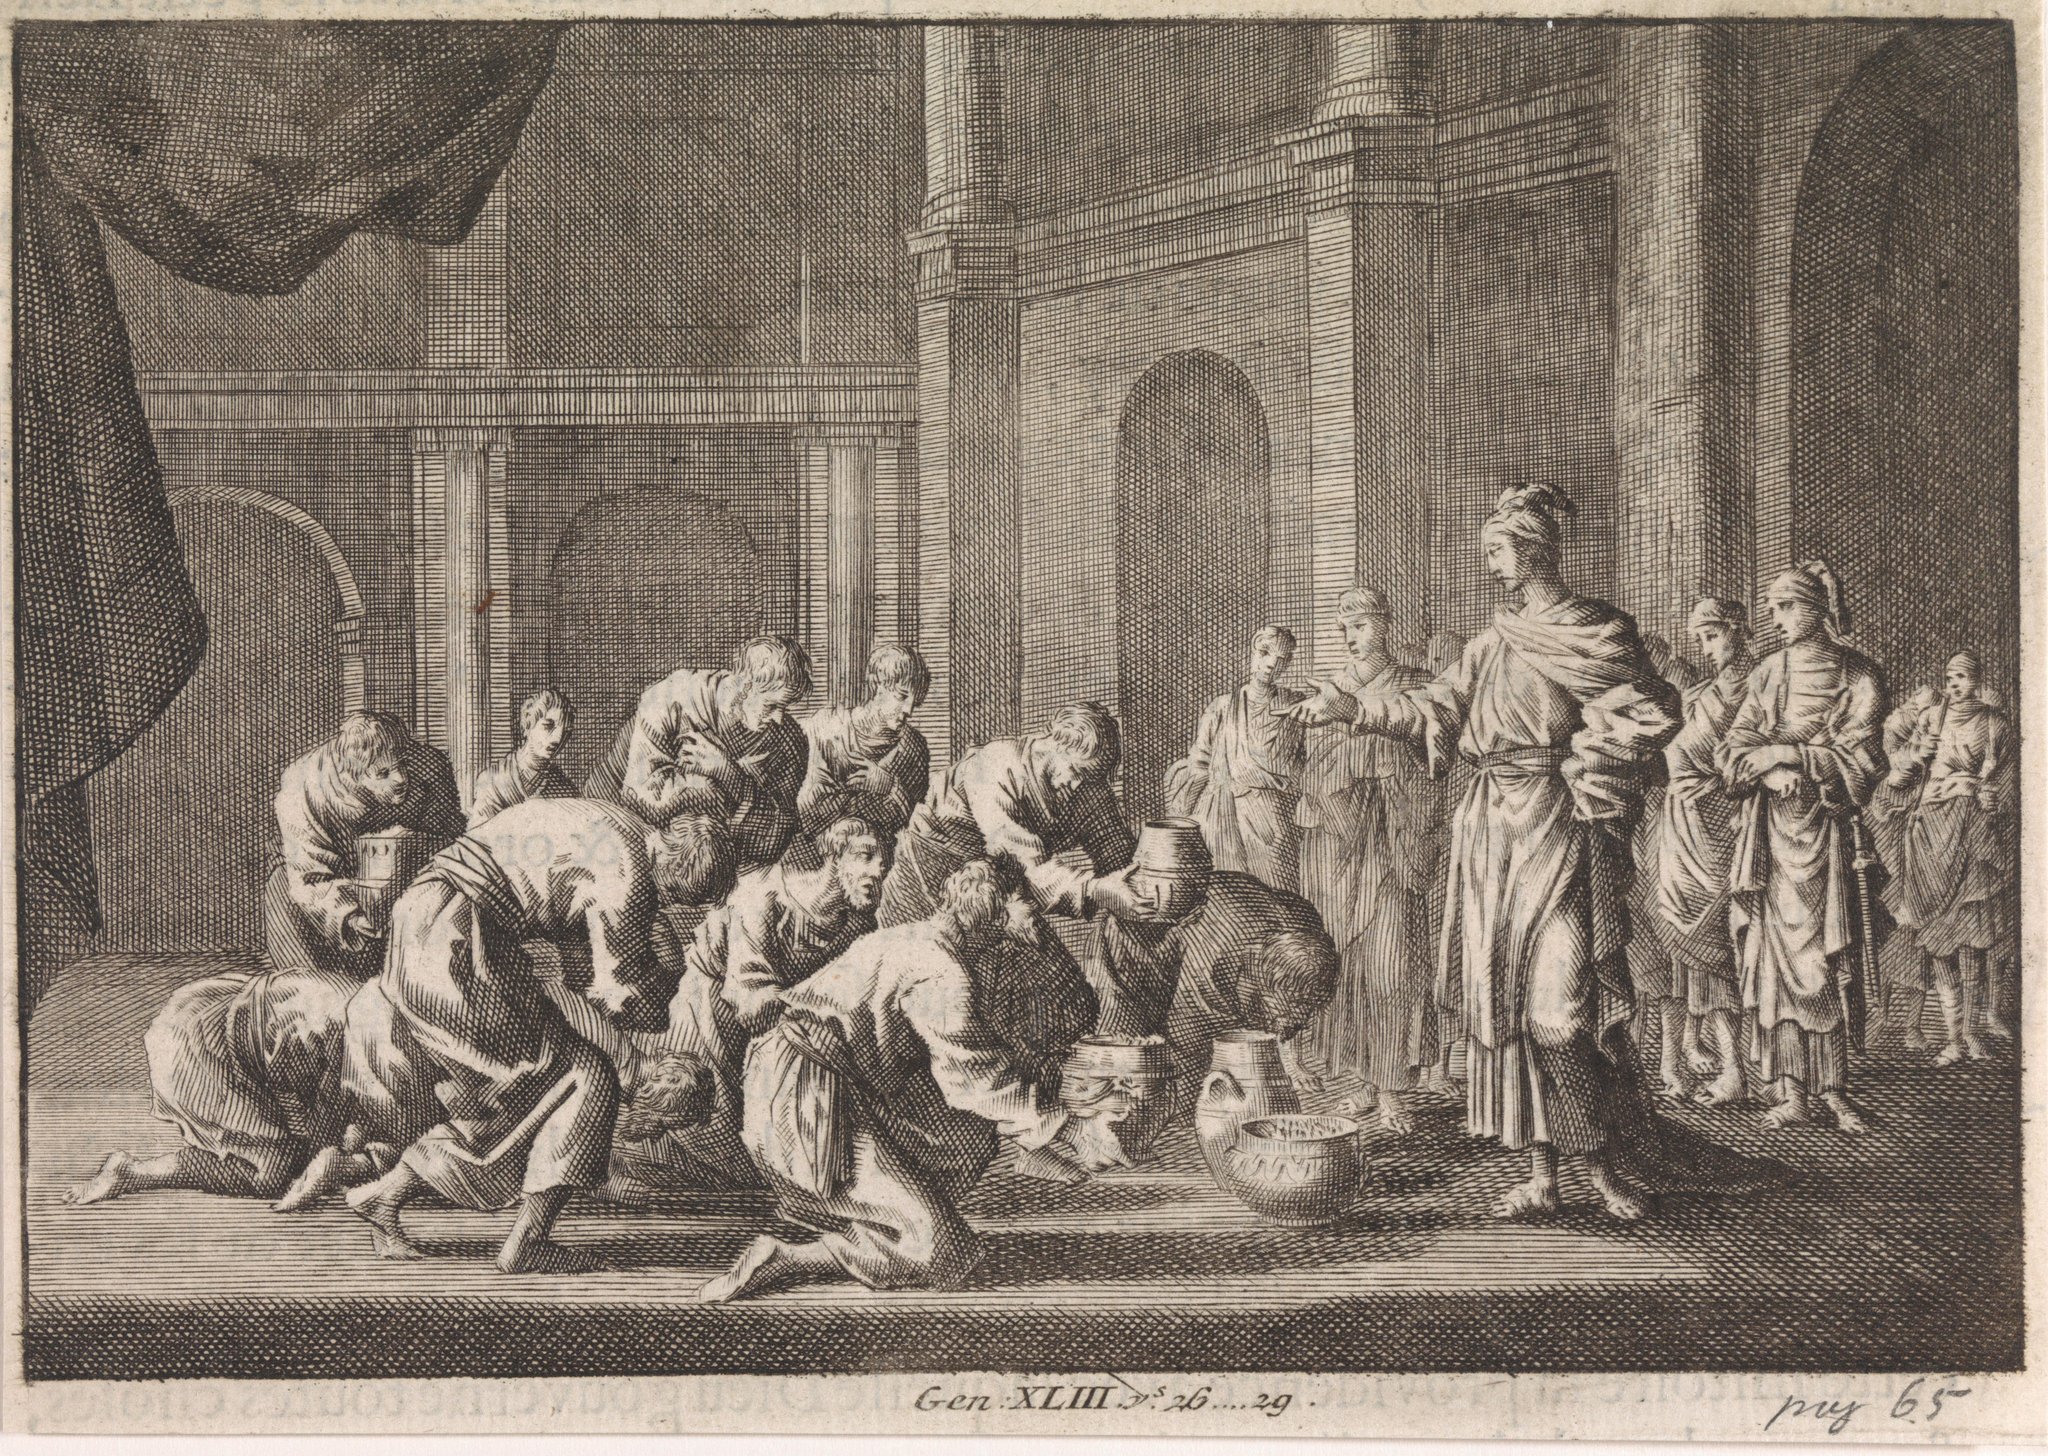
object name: book illustration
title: Jozefs broers knielen voor hem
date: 1703-1762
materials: paper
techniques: etching, letterpress printing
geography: amsterdam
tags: admitted in joseph's presence, the brothers bow down before him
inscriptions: collector's mark: Lugt 2228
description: De prent komt een eerste keer voor als boekillustratie voor David Martin. Historie des Ouden en Nieuwen Testaments. Amsterdam, Pieter Mortier, 1703. Deel I. De boekillustraties voor de Mortierbijbel hebben verschillende staten en kopieën, waarbij de chronologische volgorde moeilijk te achterhalen valt. Als boekillustraties werden ze bovendien herhaaldelijk opnieuw gebruikt voor andere boekwerken.